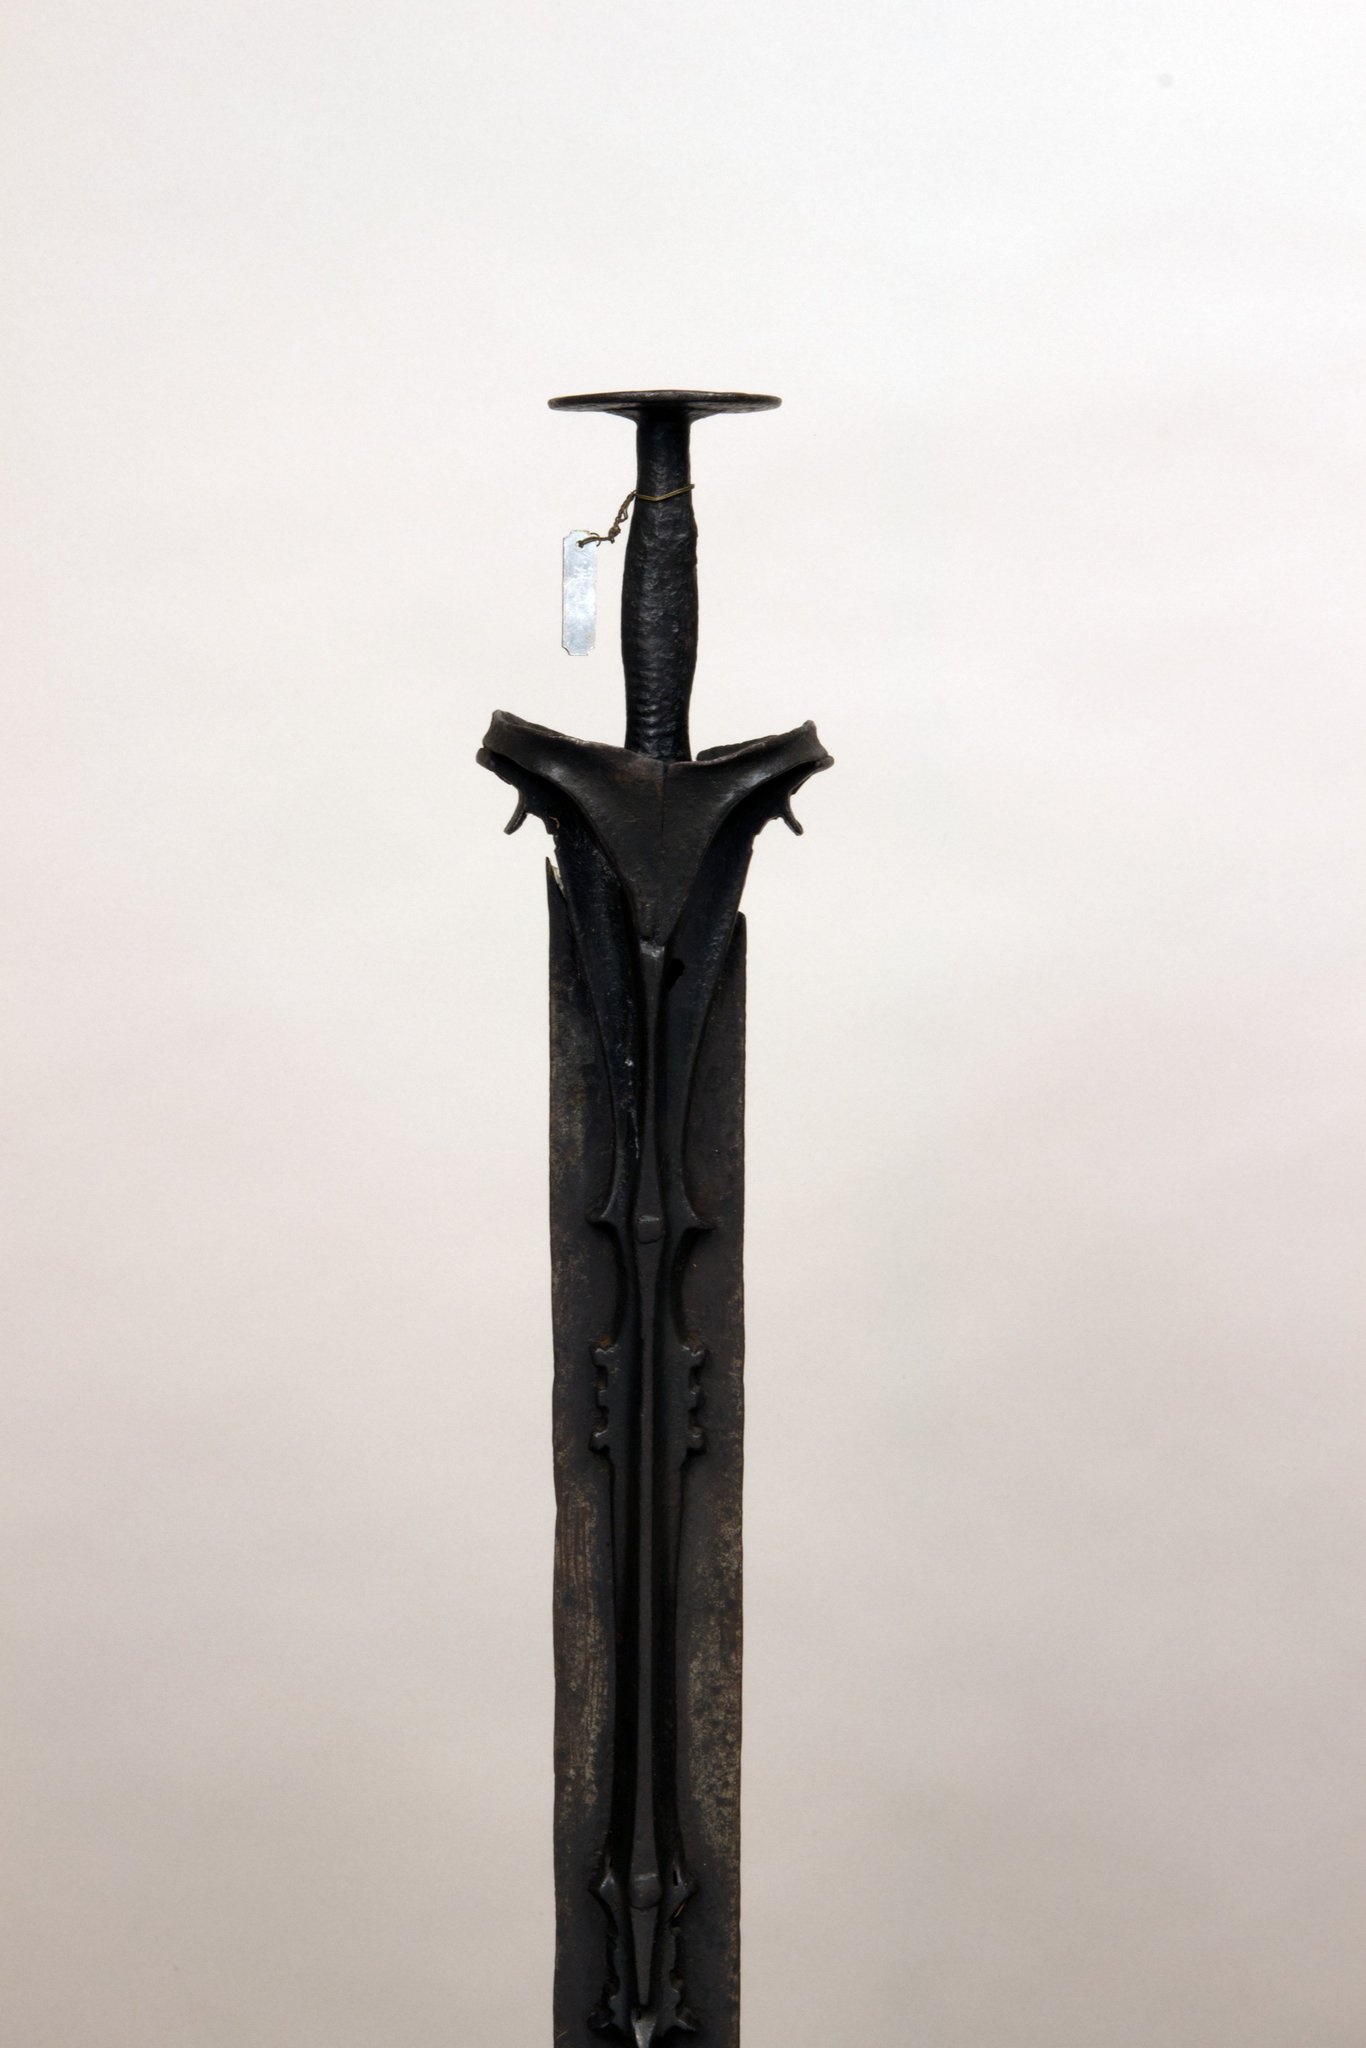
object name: sword arivāl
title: Sword (Arivāl)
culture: south indian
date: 1501-1600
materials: steel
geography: india